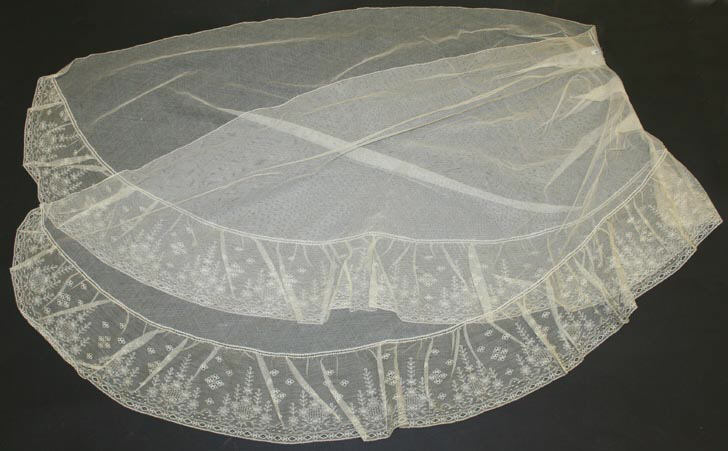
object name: fichu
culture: american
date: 1700-1941